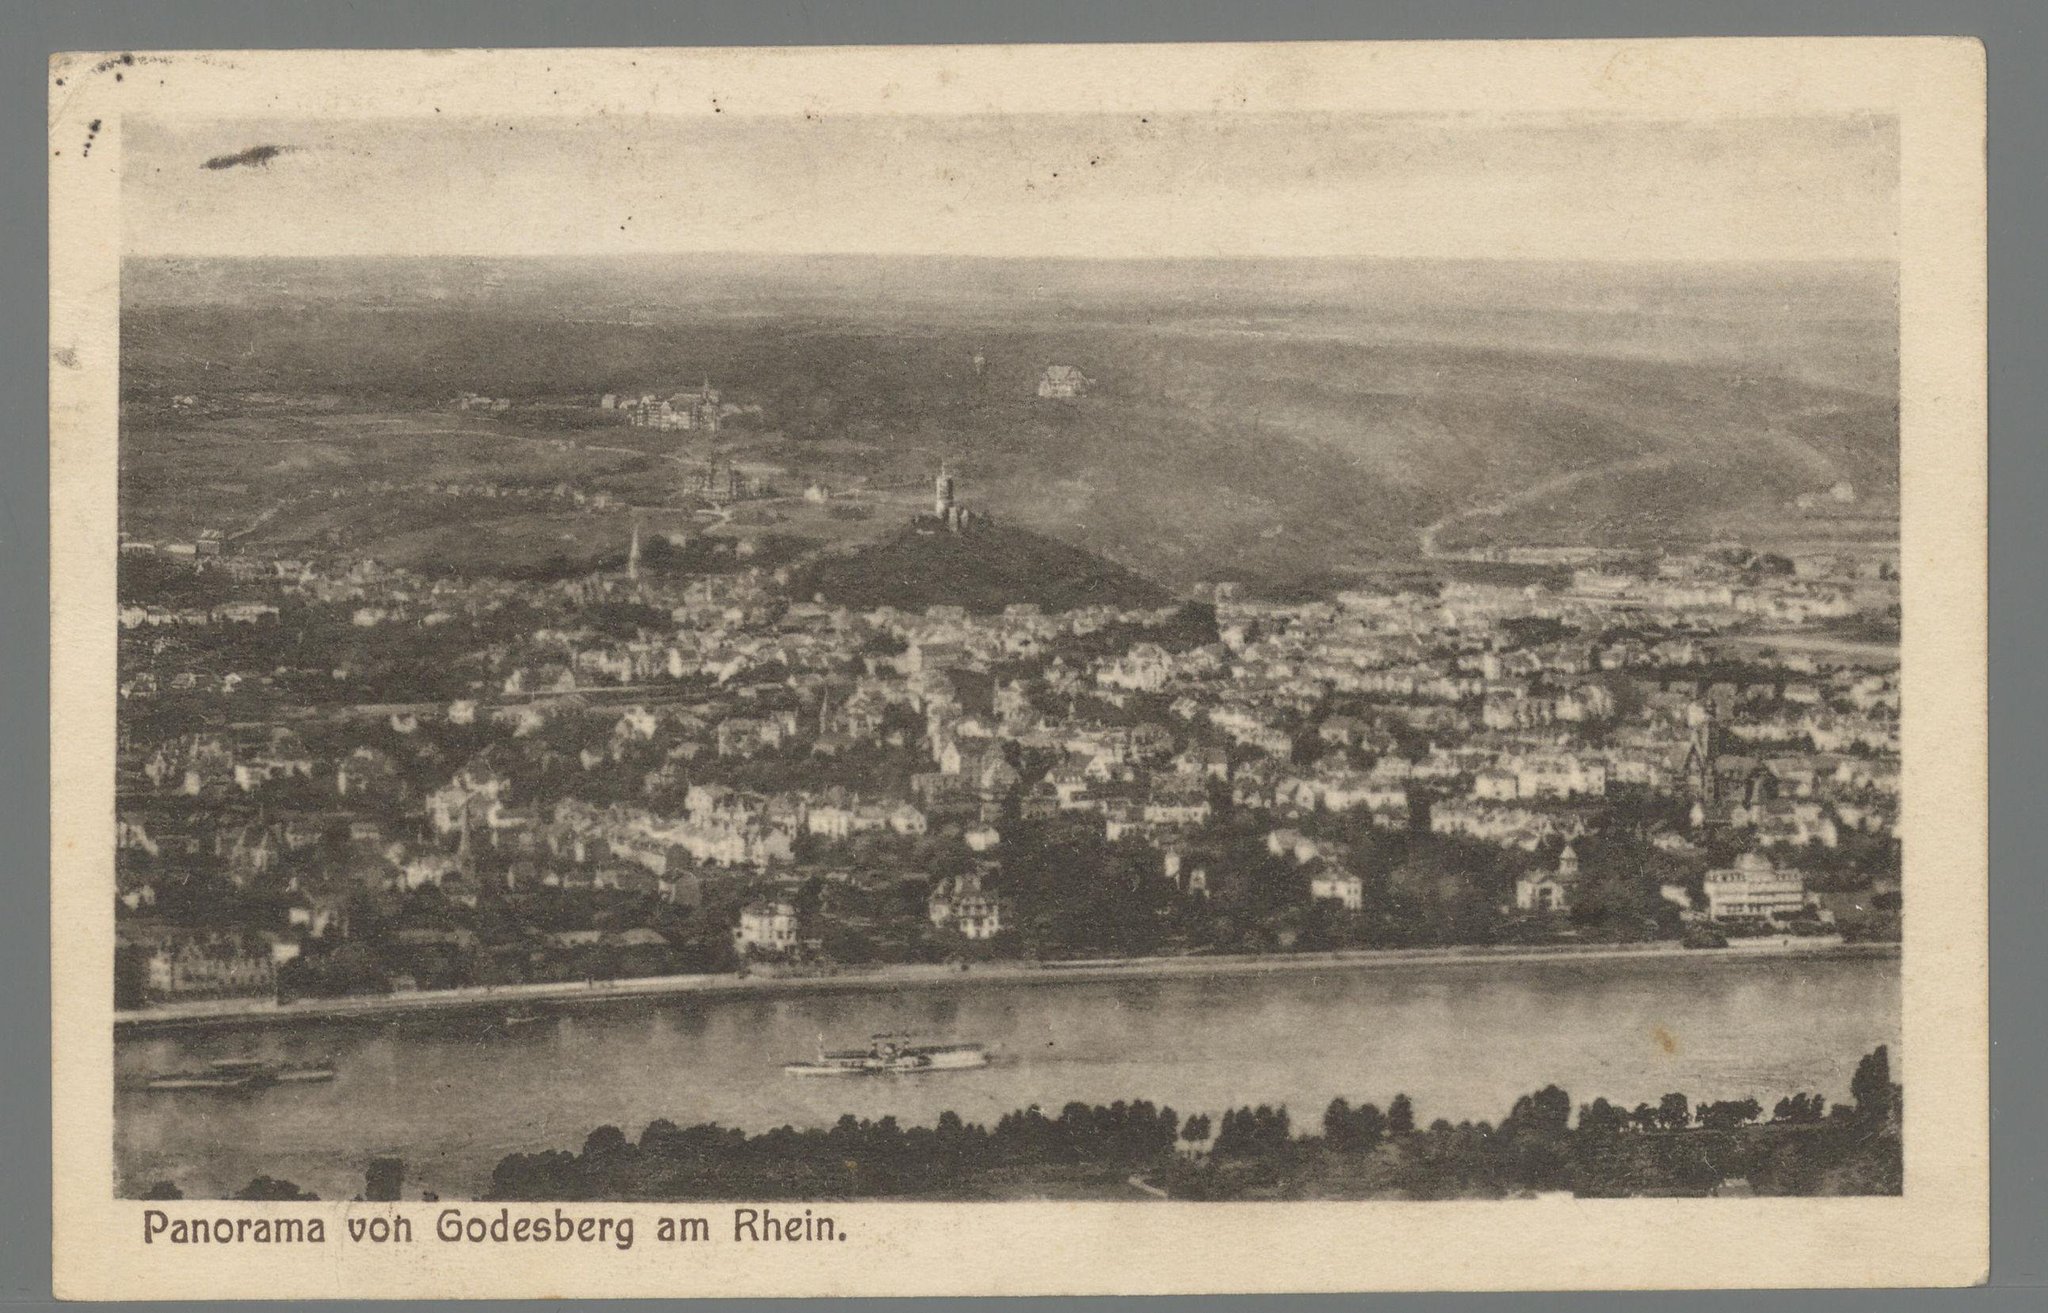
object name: photomechanical print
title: Panorama von Godesberg am Rhein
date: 1905-1930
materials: cardboard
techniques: photograph, writing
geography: bad godesberg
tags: river, prospect of city, town panorama, silhouette of city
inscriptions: poststempel, verso, gestempeld